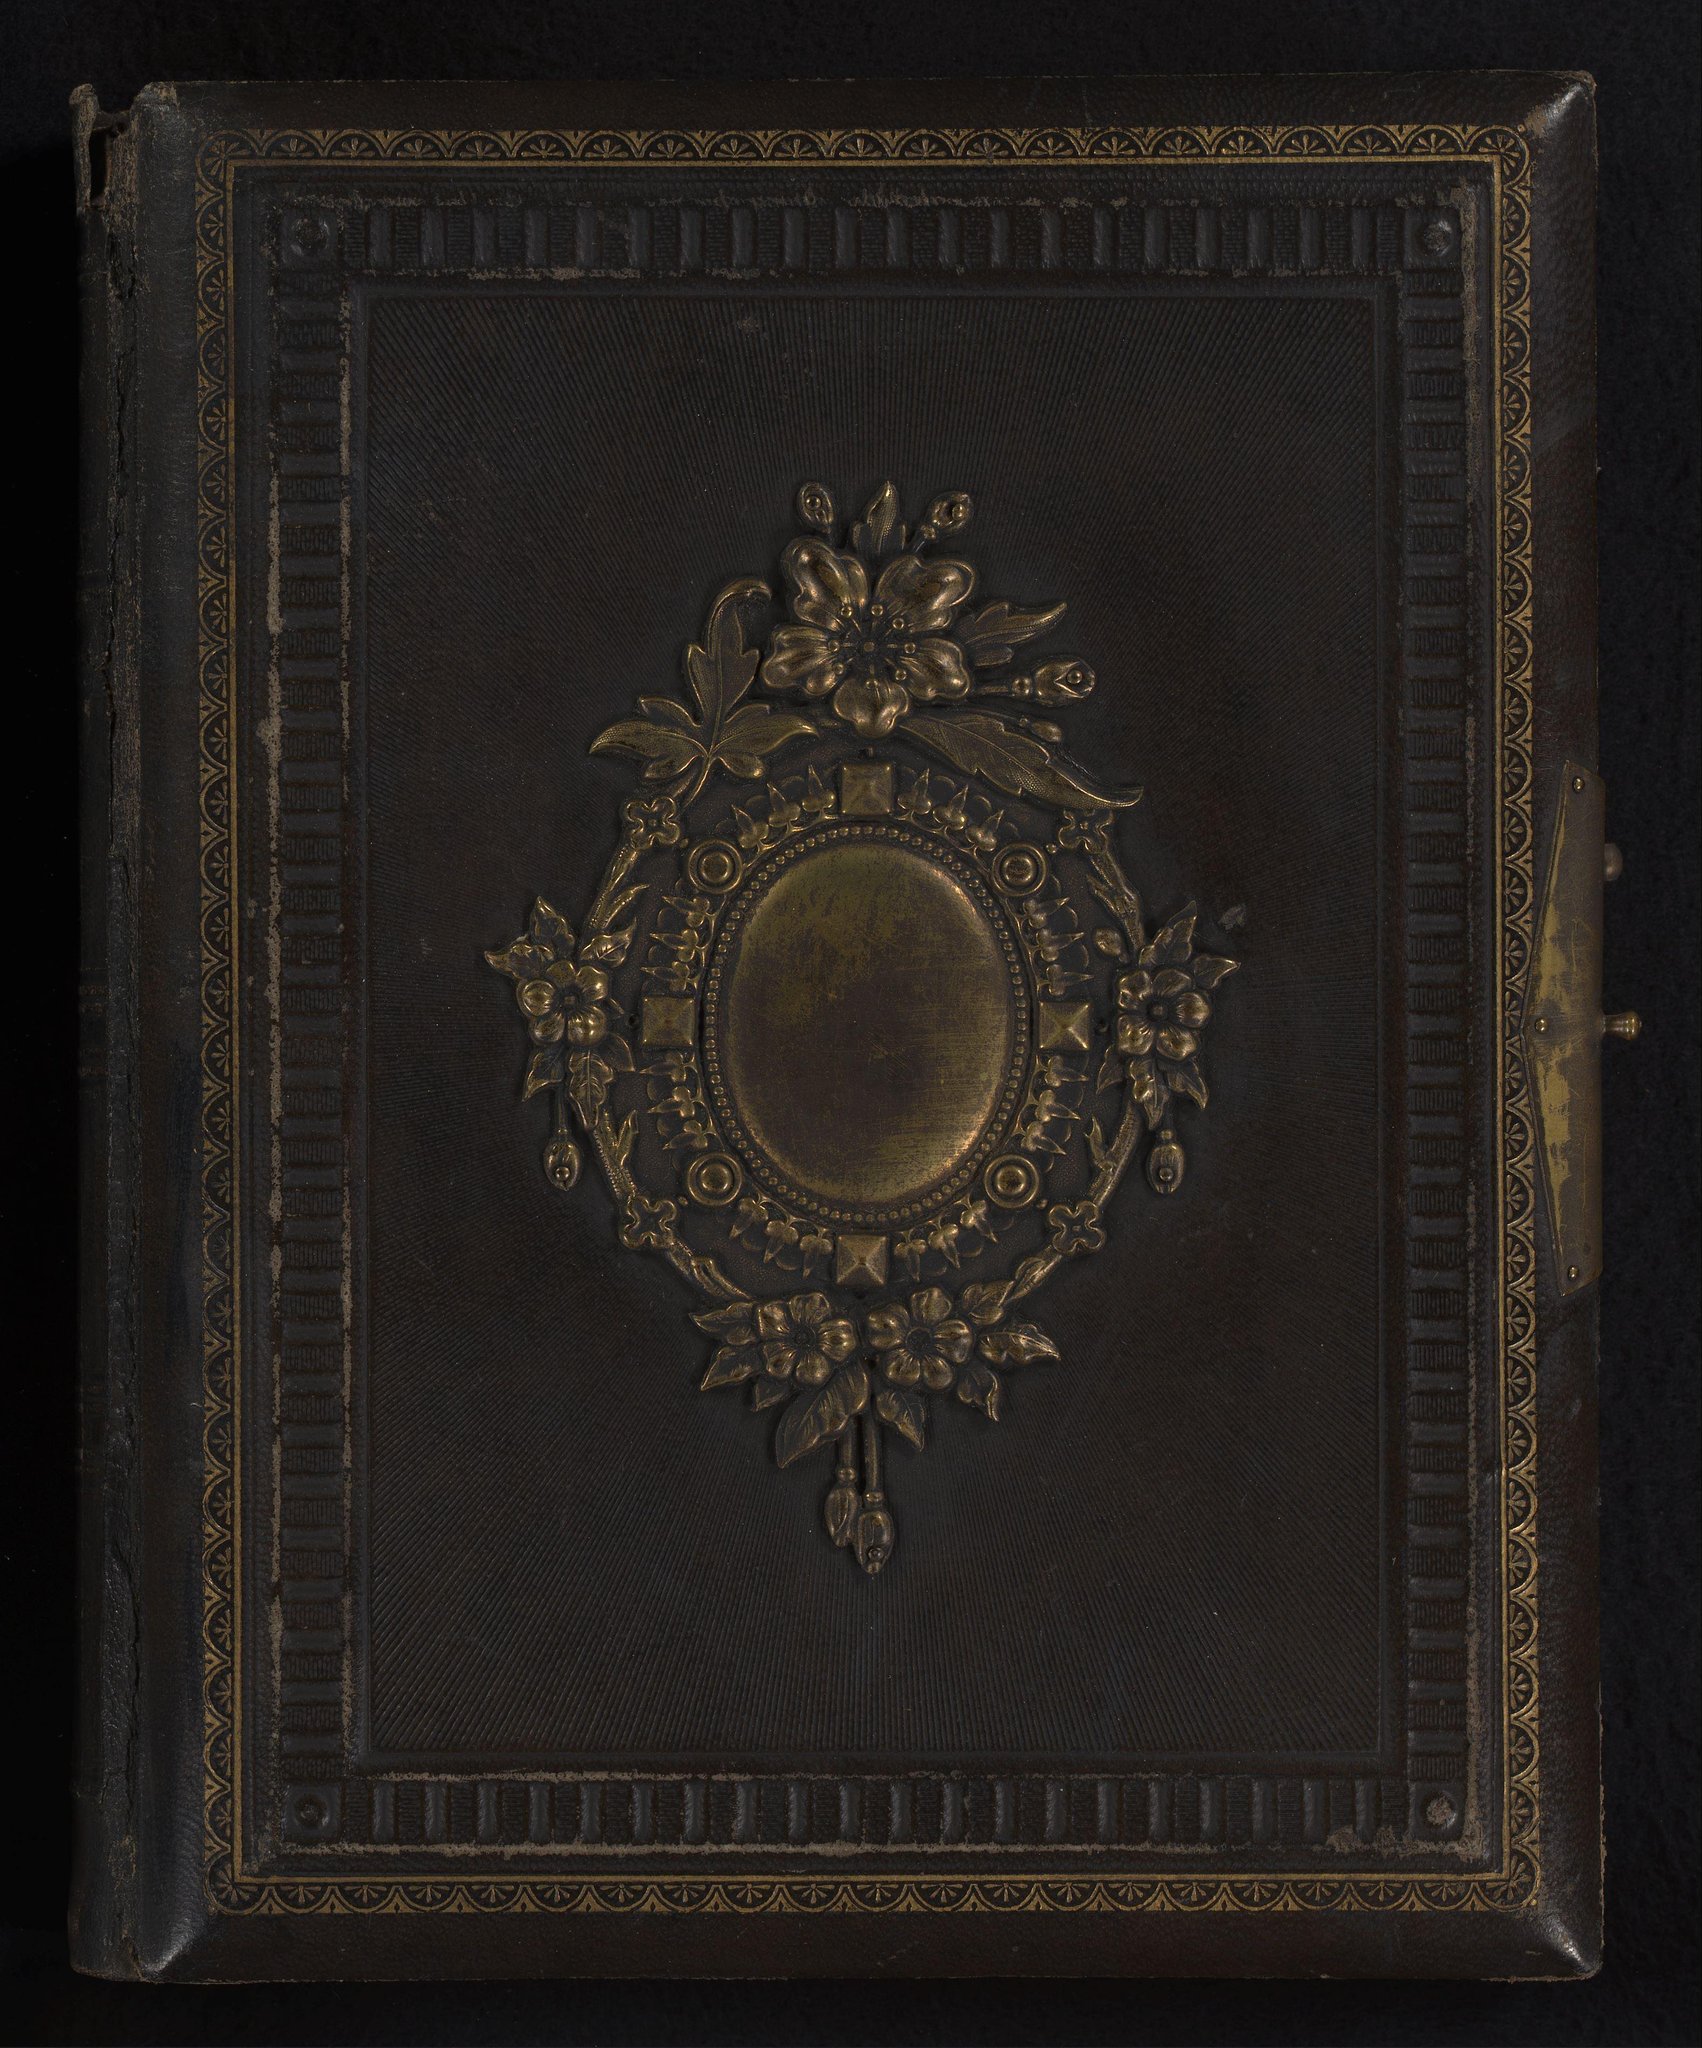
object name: slip in album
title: Nederlands fotoalbum met 81 foto's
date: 1860-1920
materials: cardboard, copper, leather, paper, photographic support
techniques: albumen print, lithograph, decorated paper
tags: the hague, print maker, wilhelmina of the netherlands, adolescent, young woman, maiden, historical persons - bb - woman, historical persons, youth, adolescent, head-gear: cap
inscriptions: collector's mark: ‘Dienst Verspreide Rijkskollekties (...) A817’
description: Fotoalbum met 81 foto's op 22 bladen met insteekpasse-partouts. Het album bevat voornamelijk portretten, onder andere een van prinses Wilhelmina. Daarnaast bevat het album twee fotoreproducties van schilderijen, een foto van een school en een foto van een monument. De foto's zijn onder andere vervaardigd door Albert Greiner, Cornelis Bernardus Broersma en W.G. Kuijer, enkele foto's zijn anoniem.